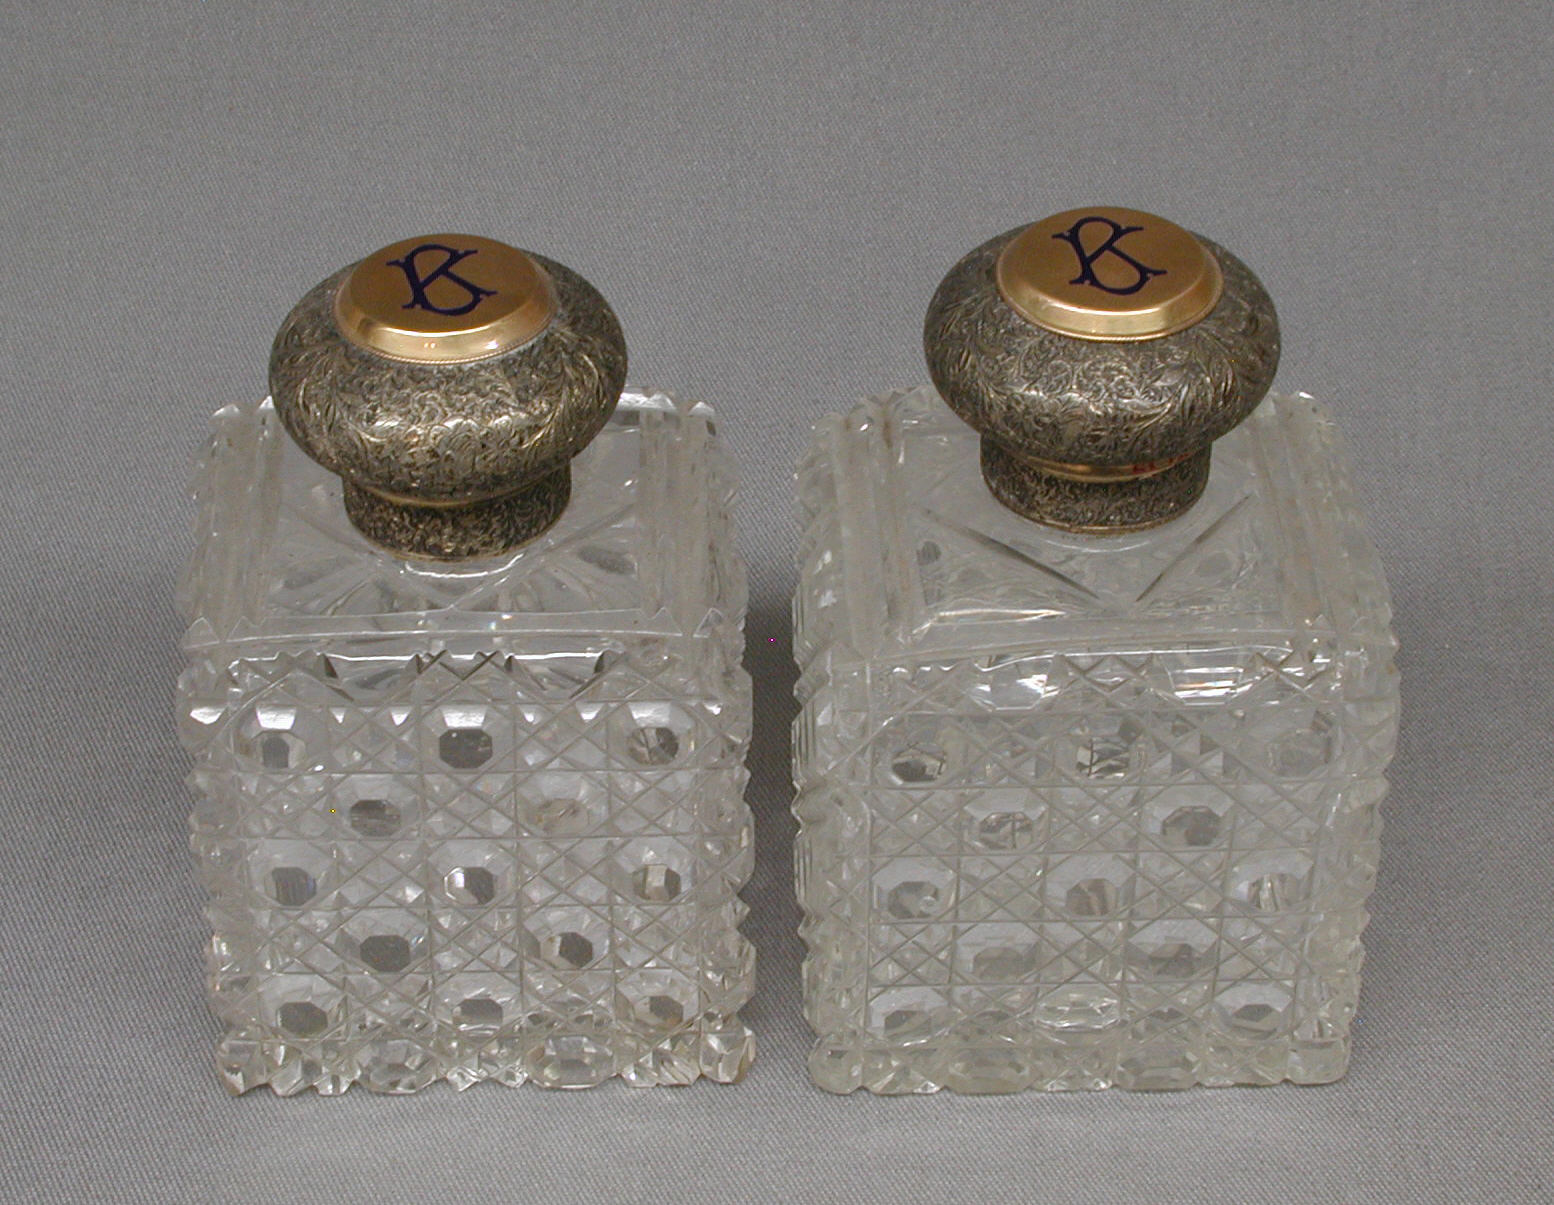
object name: bottle with cover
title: Square bottle with cover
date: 1874-1875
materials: glass, silver